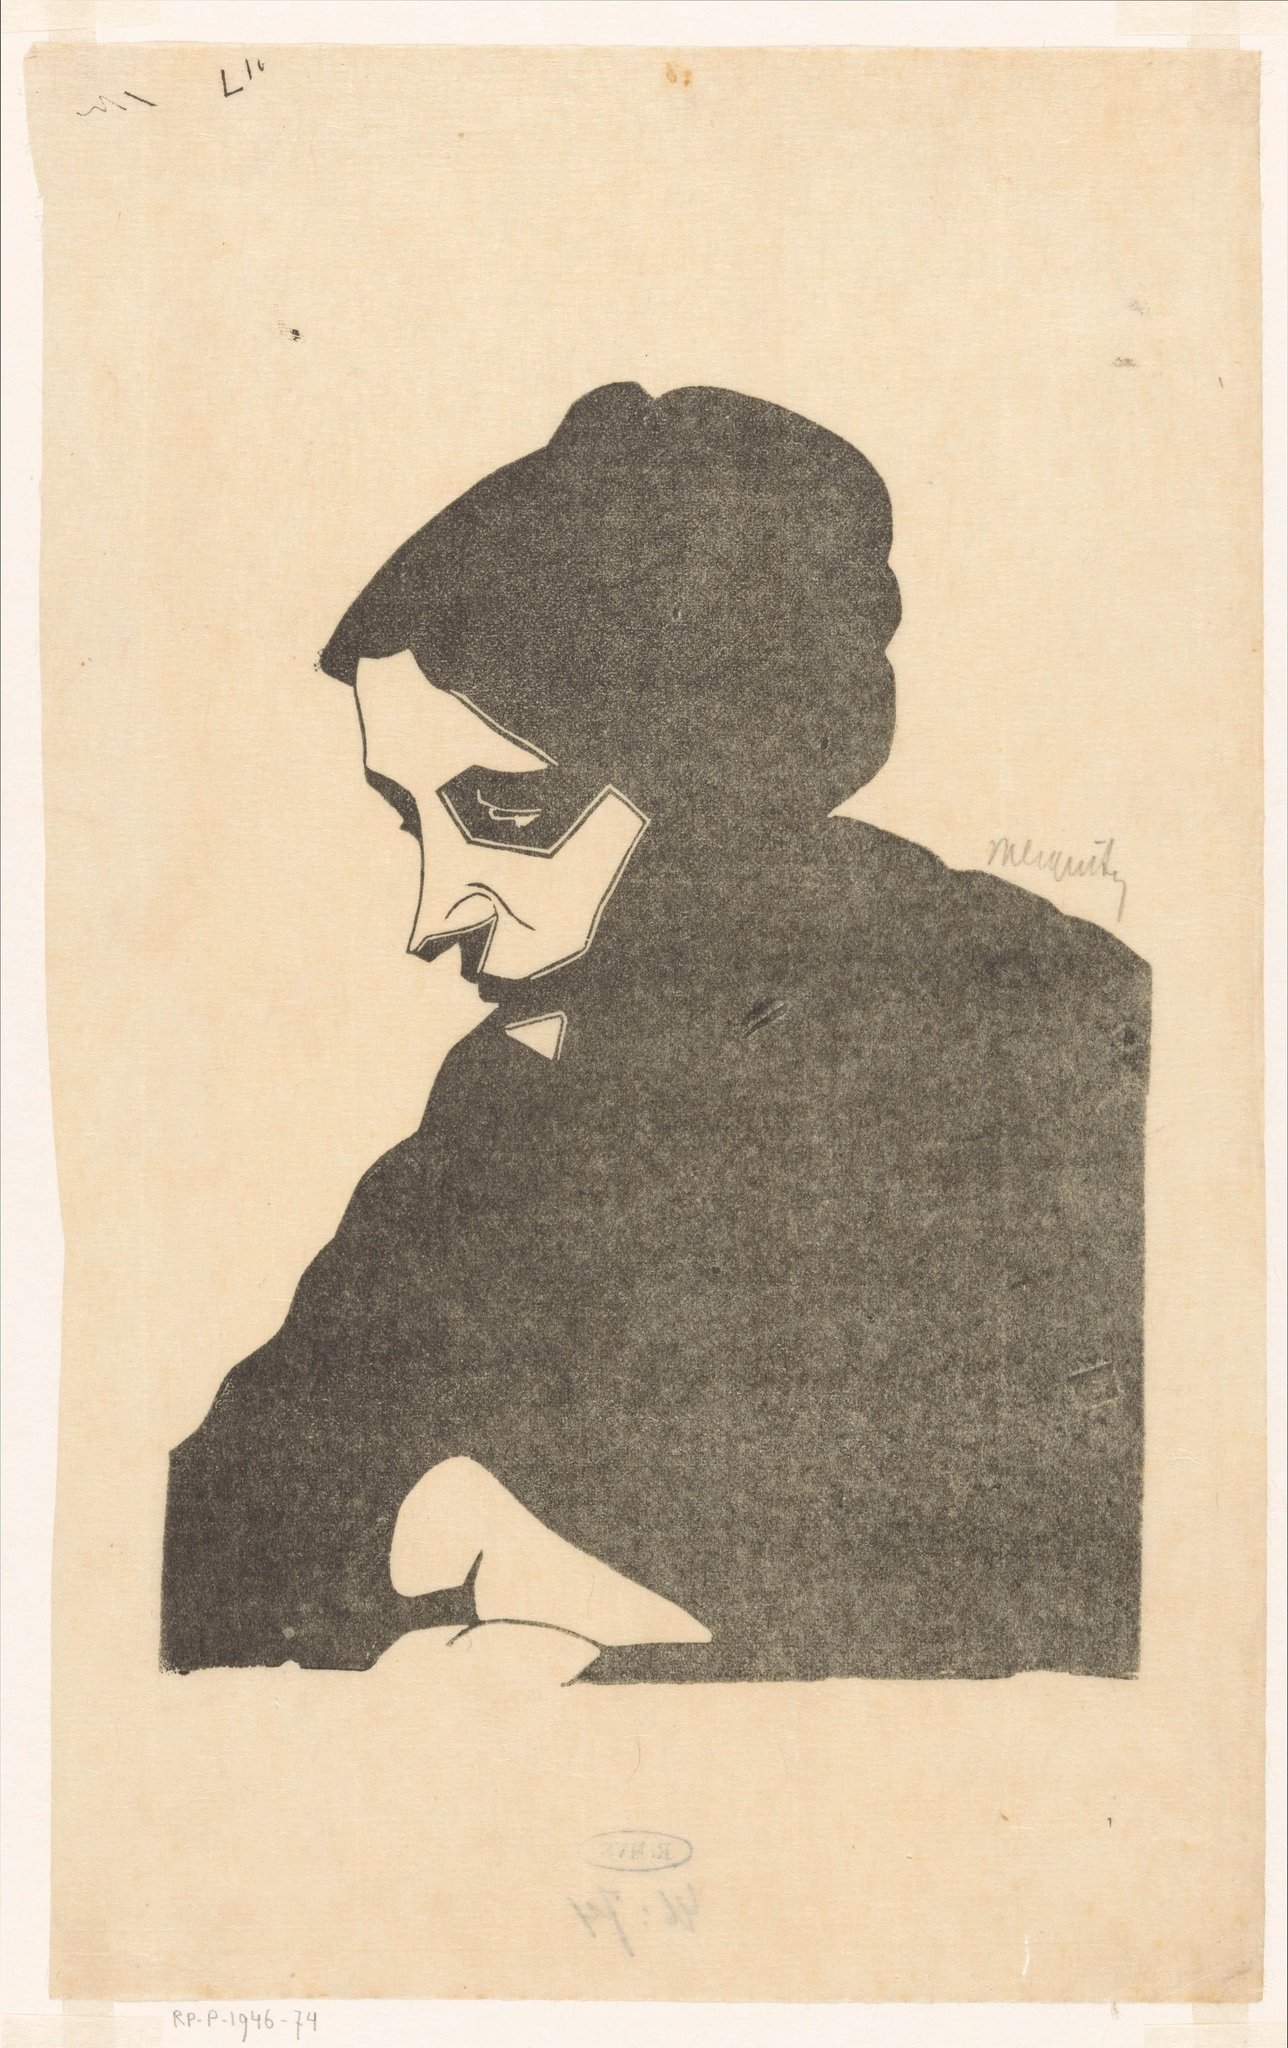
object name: print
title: Portret van een onbekende vrouw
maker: samuel jessurun de mesquita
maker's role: draughtsman, print maker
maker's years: 1868-1944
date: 1913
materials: paper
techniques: woodcut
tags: adult woman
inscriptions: signature: ‘mesquita’, collector's mark: Lugt 2228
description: Naar beneden kijkende vrouw in driekwart aanzicht naar links, met slagschaduw.